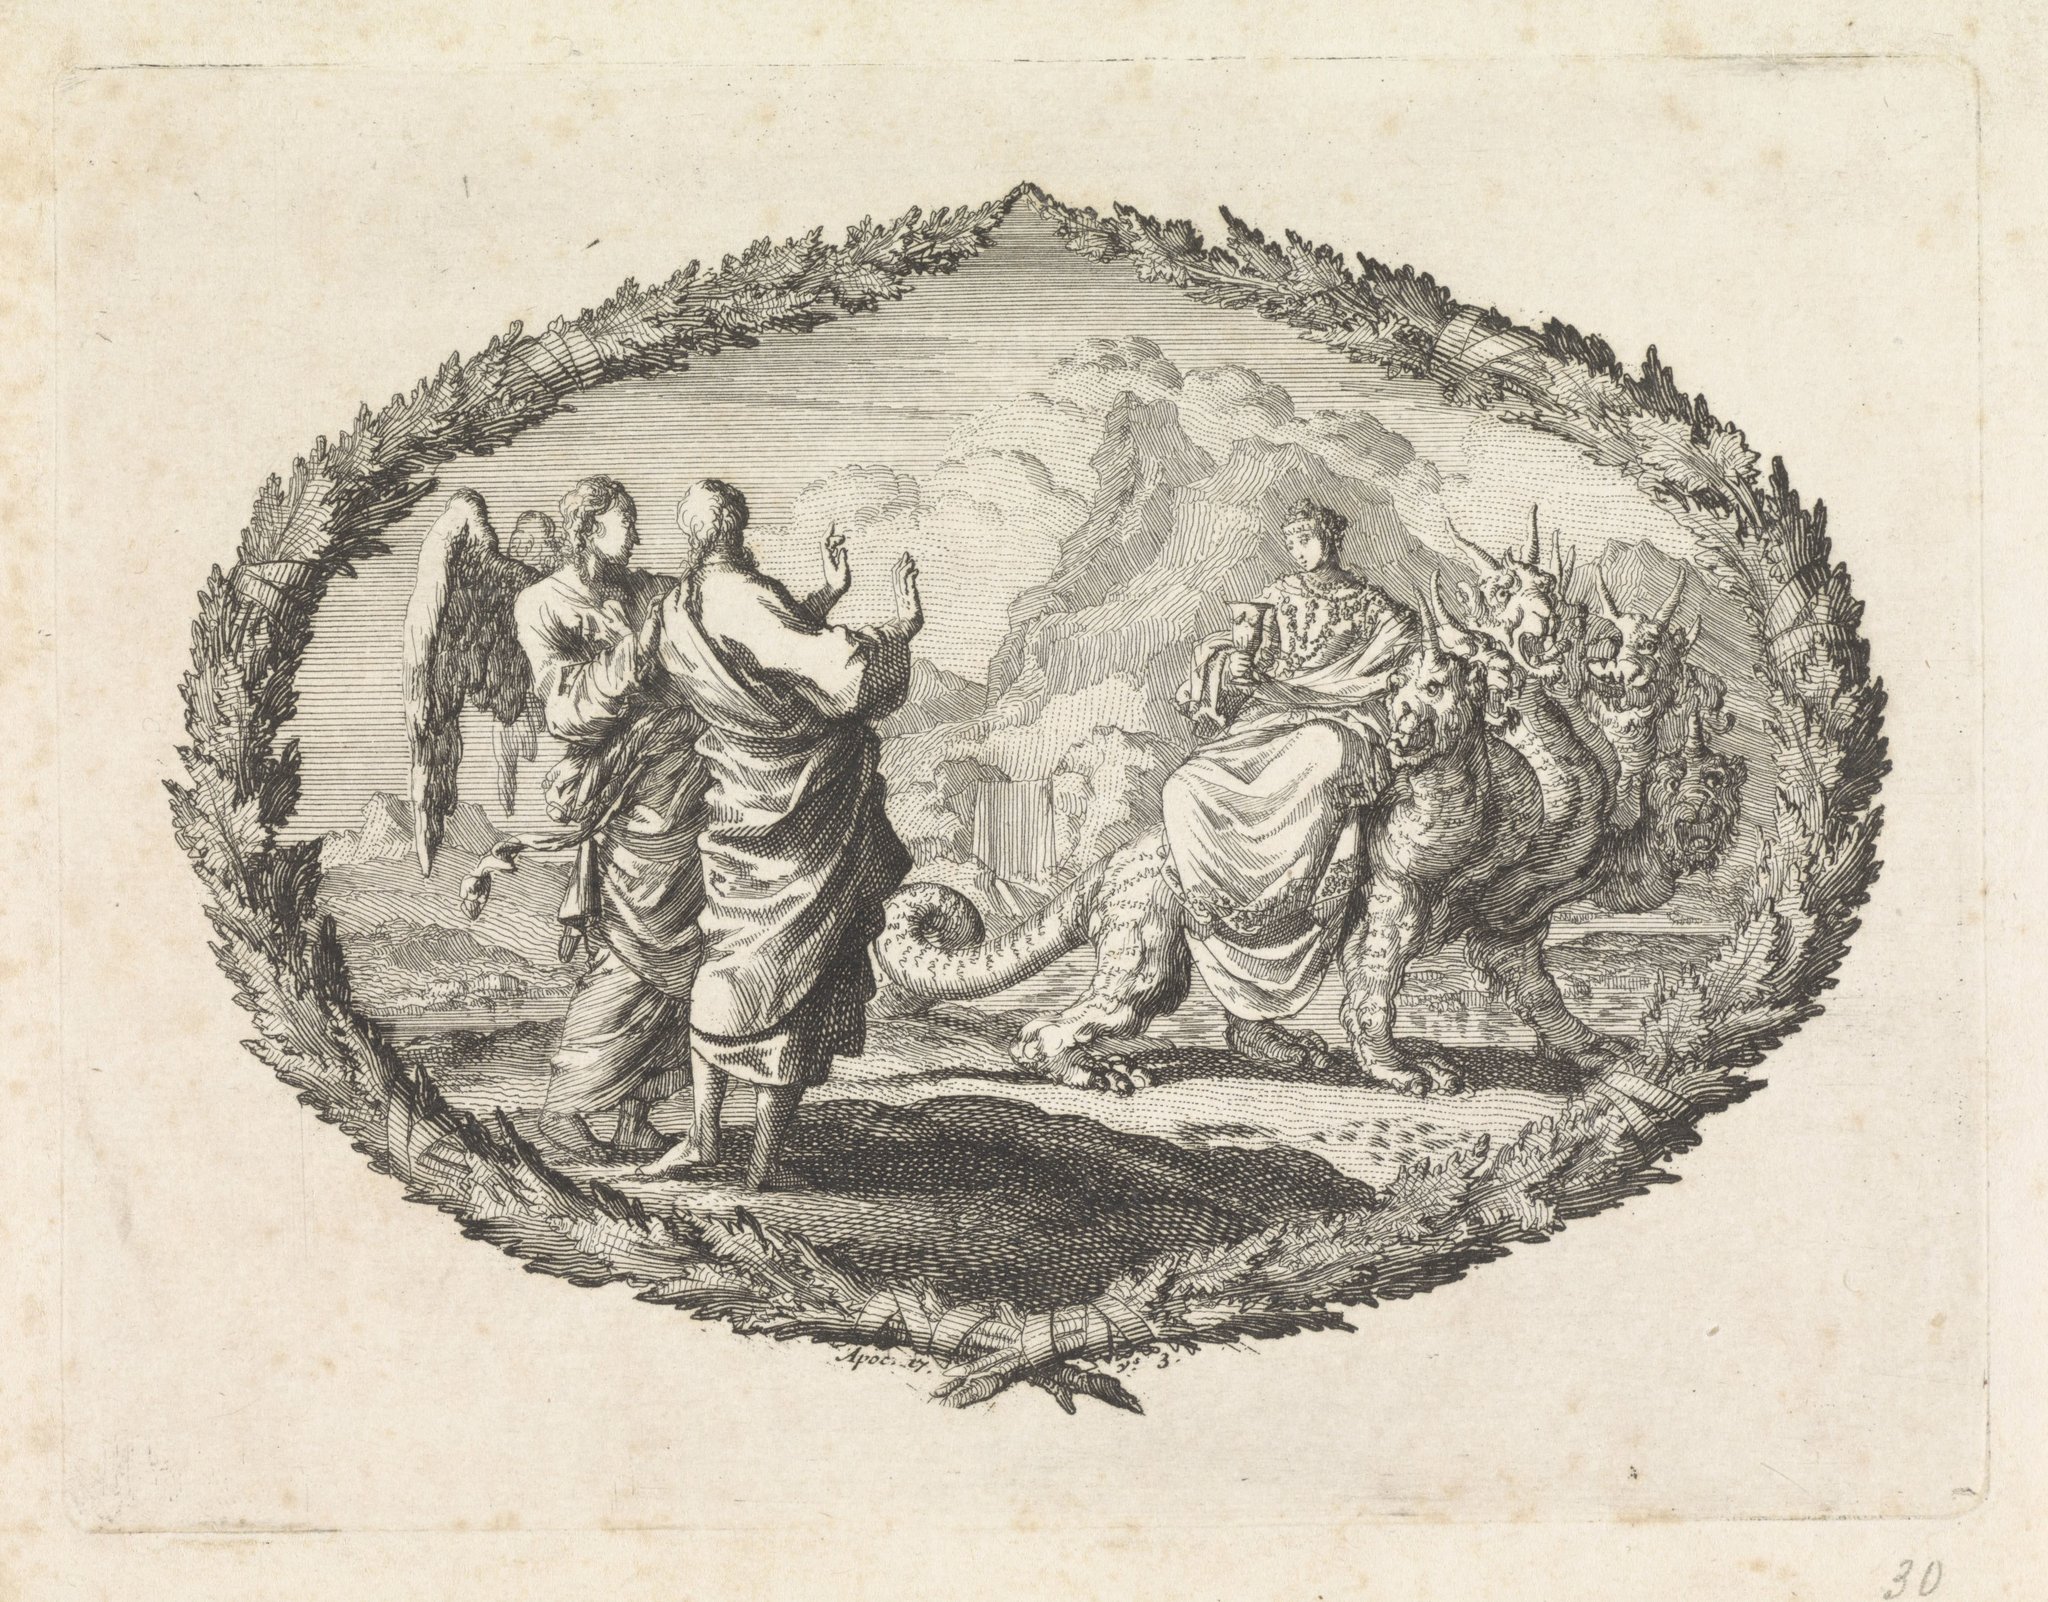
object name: print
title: Johannes ziet de hoer van Babylon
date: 1700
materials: paper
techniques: etching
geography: amsterdam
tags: the scarlet woman, the whore of babylon; she is usually sitting on a scarlet beast with seven heads and ten horns, ornament ~ cartouche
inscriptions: collector's mark: Lugt 2228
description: Een voorstelling in een cartouche van bladeren. Op de voorgrond links toont een engel Johannes de hoer Babylon, zittend op een draak met zeven koppen en tien horens. In haar hand een gouden beker. Onder de cartouche de Bijbelreferentie Op. 17:3.